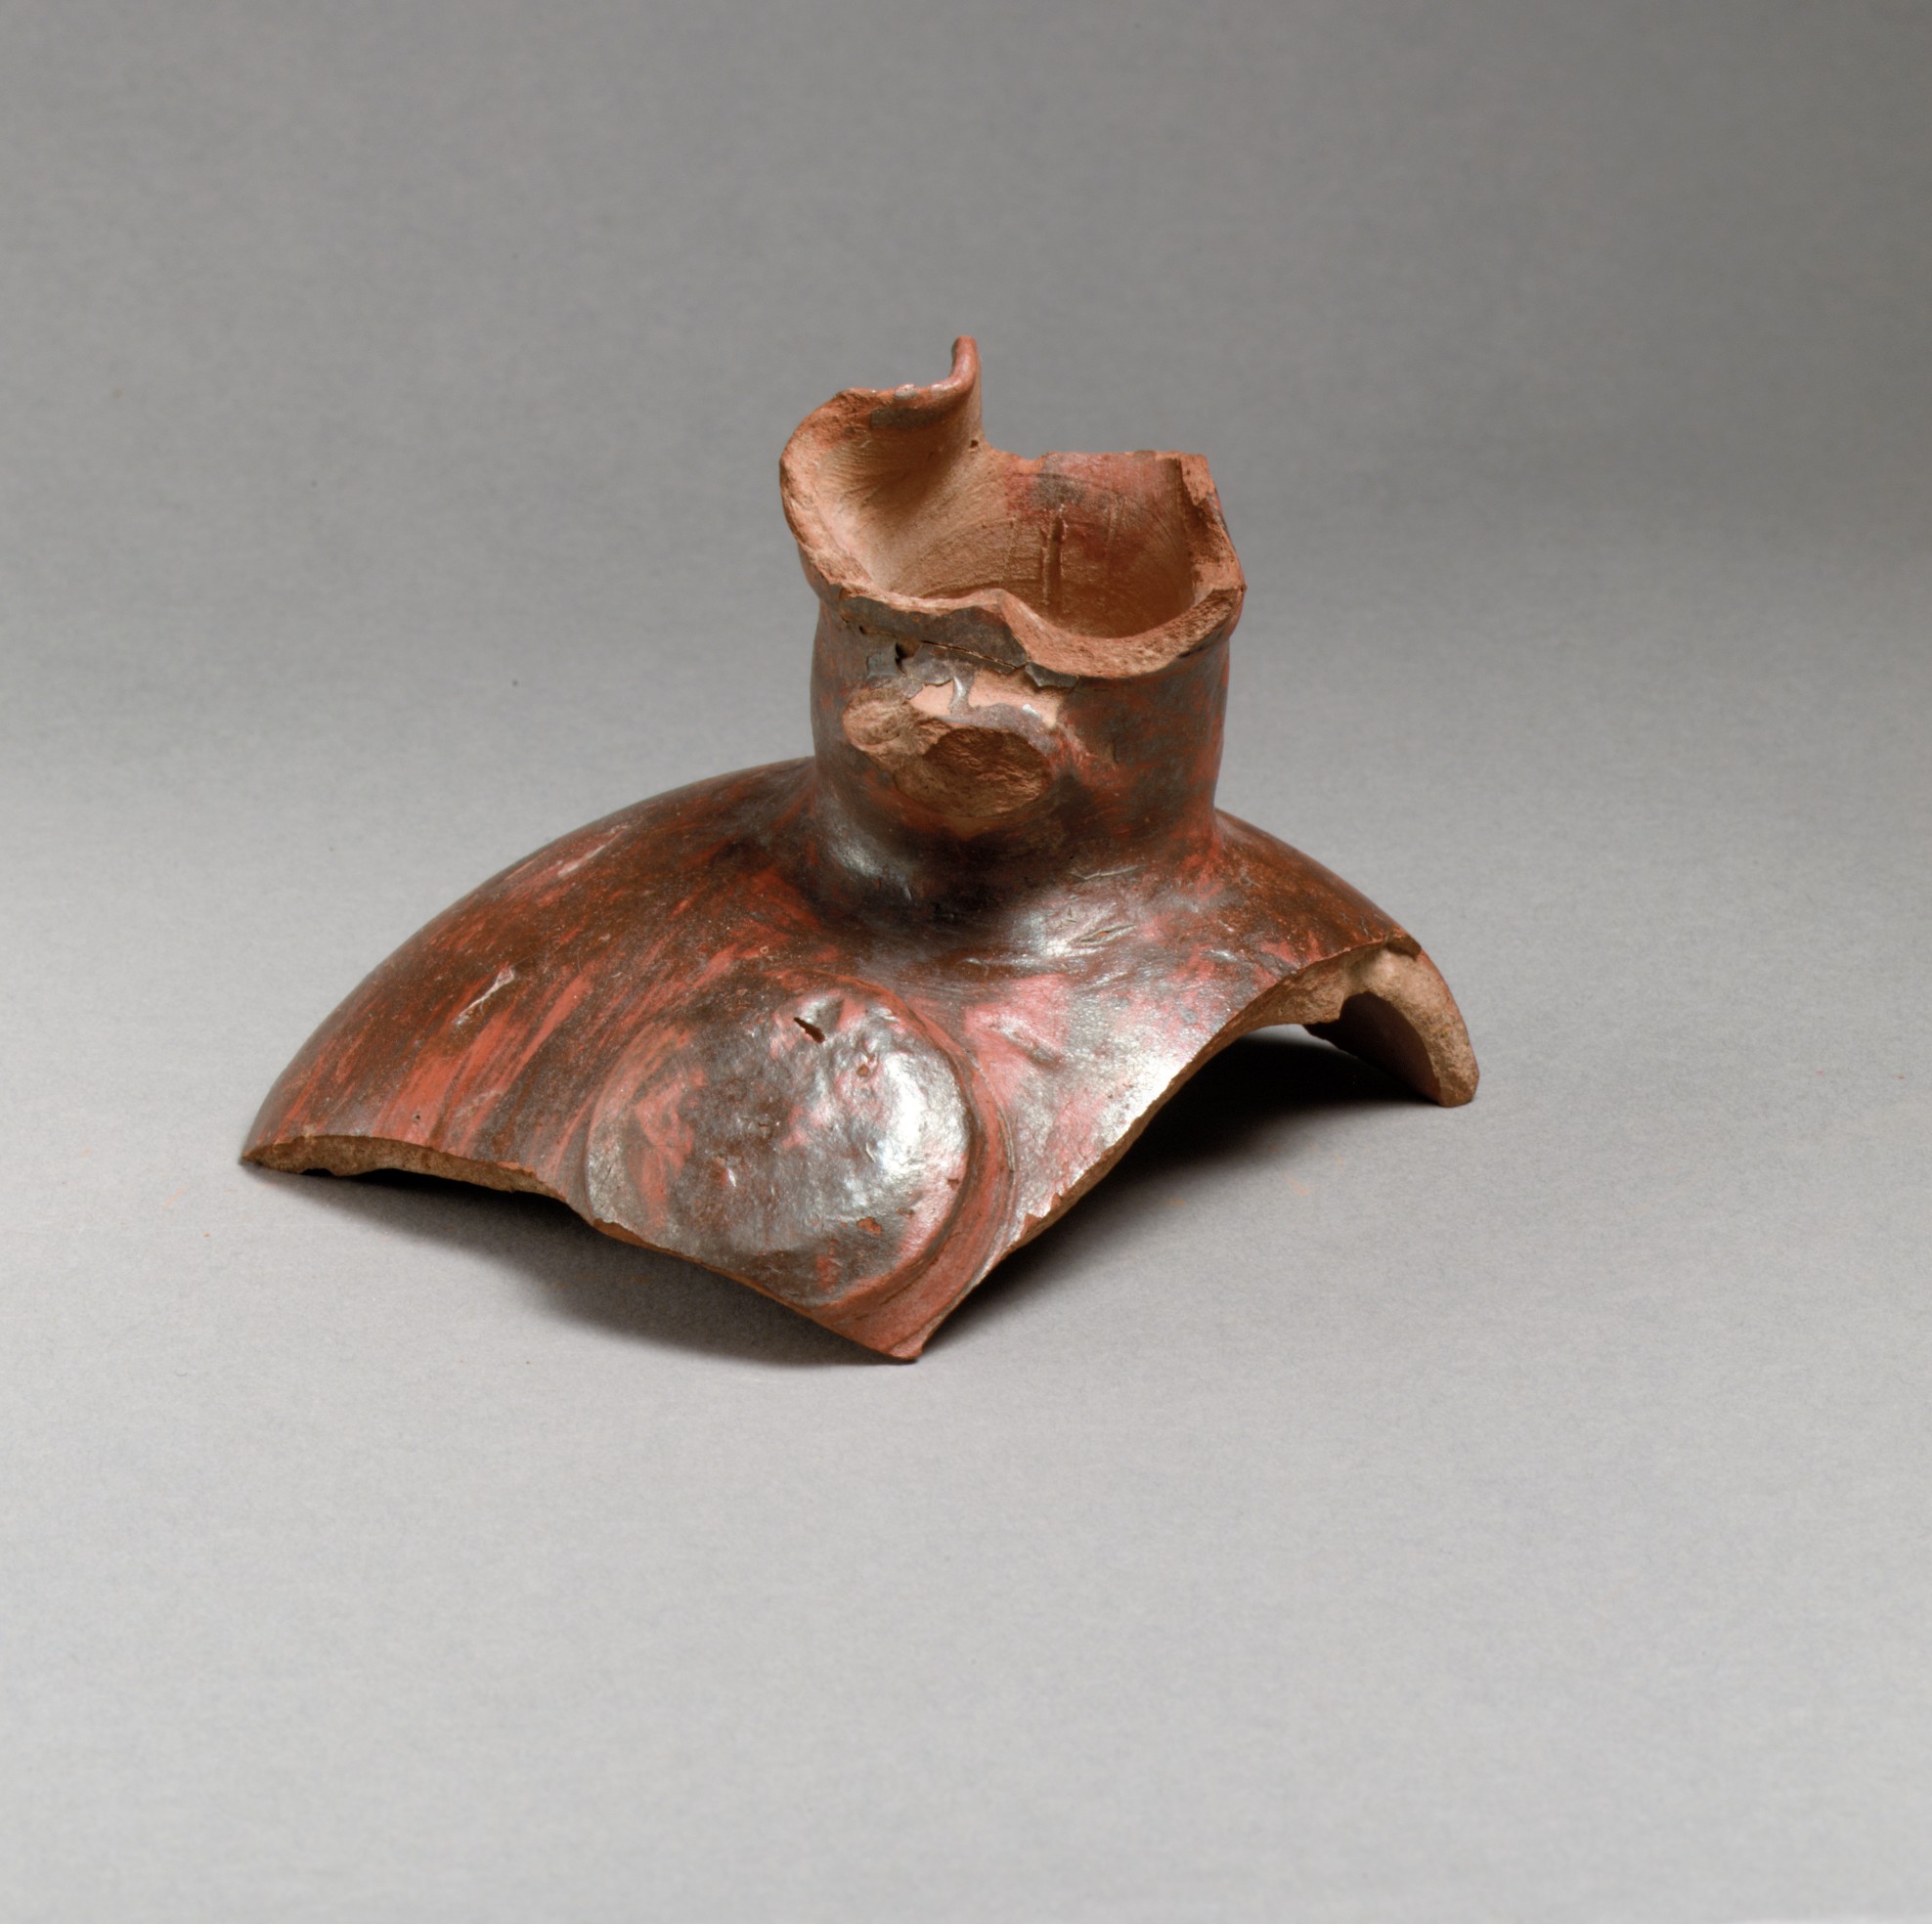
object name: vase fragment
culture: greek or lydian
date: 1050-700 BCE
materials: terracotta